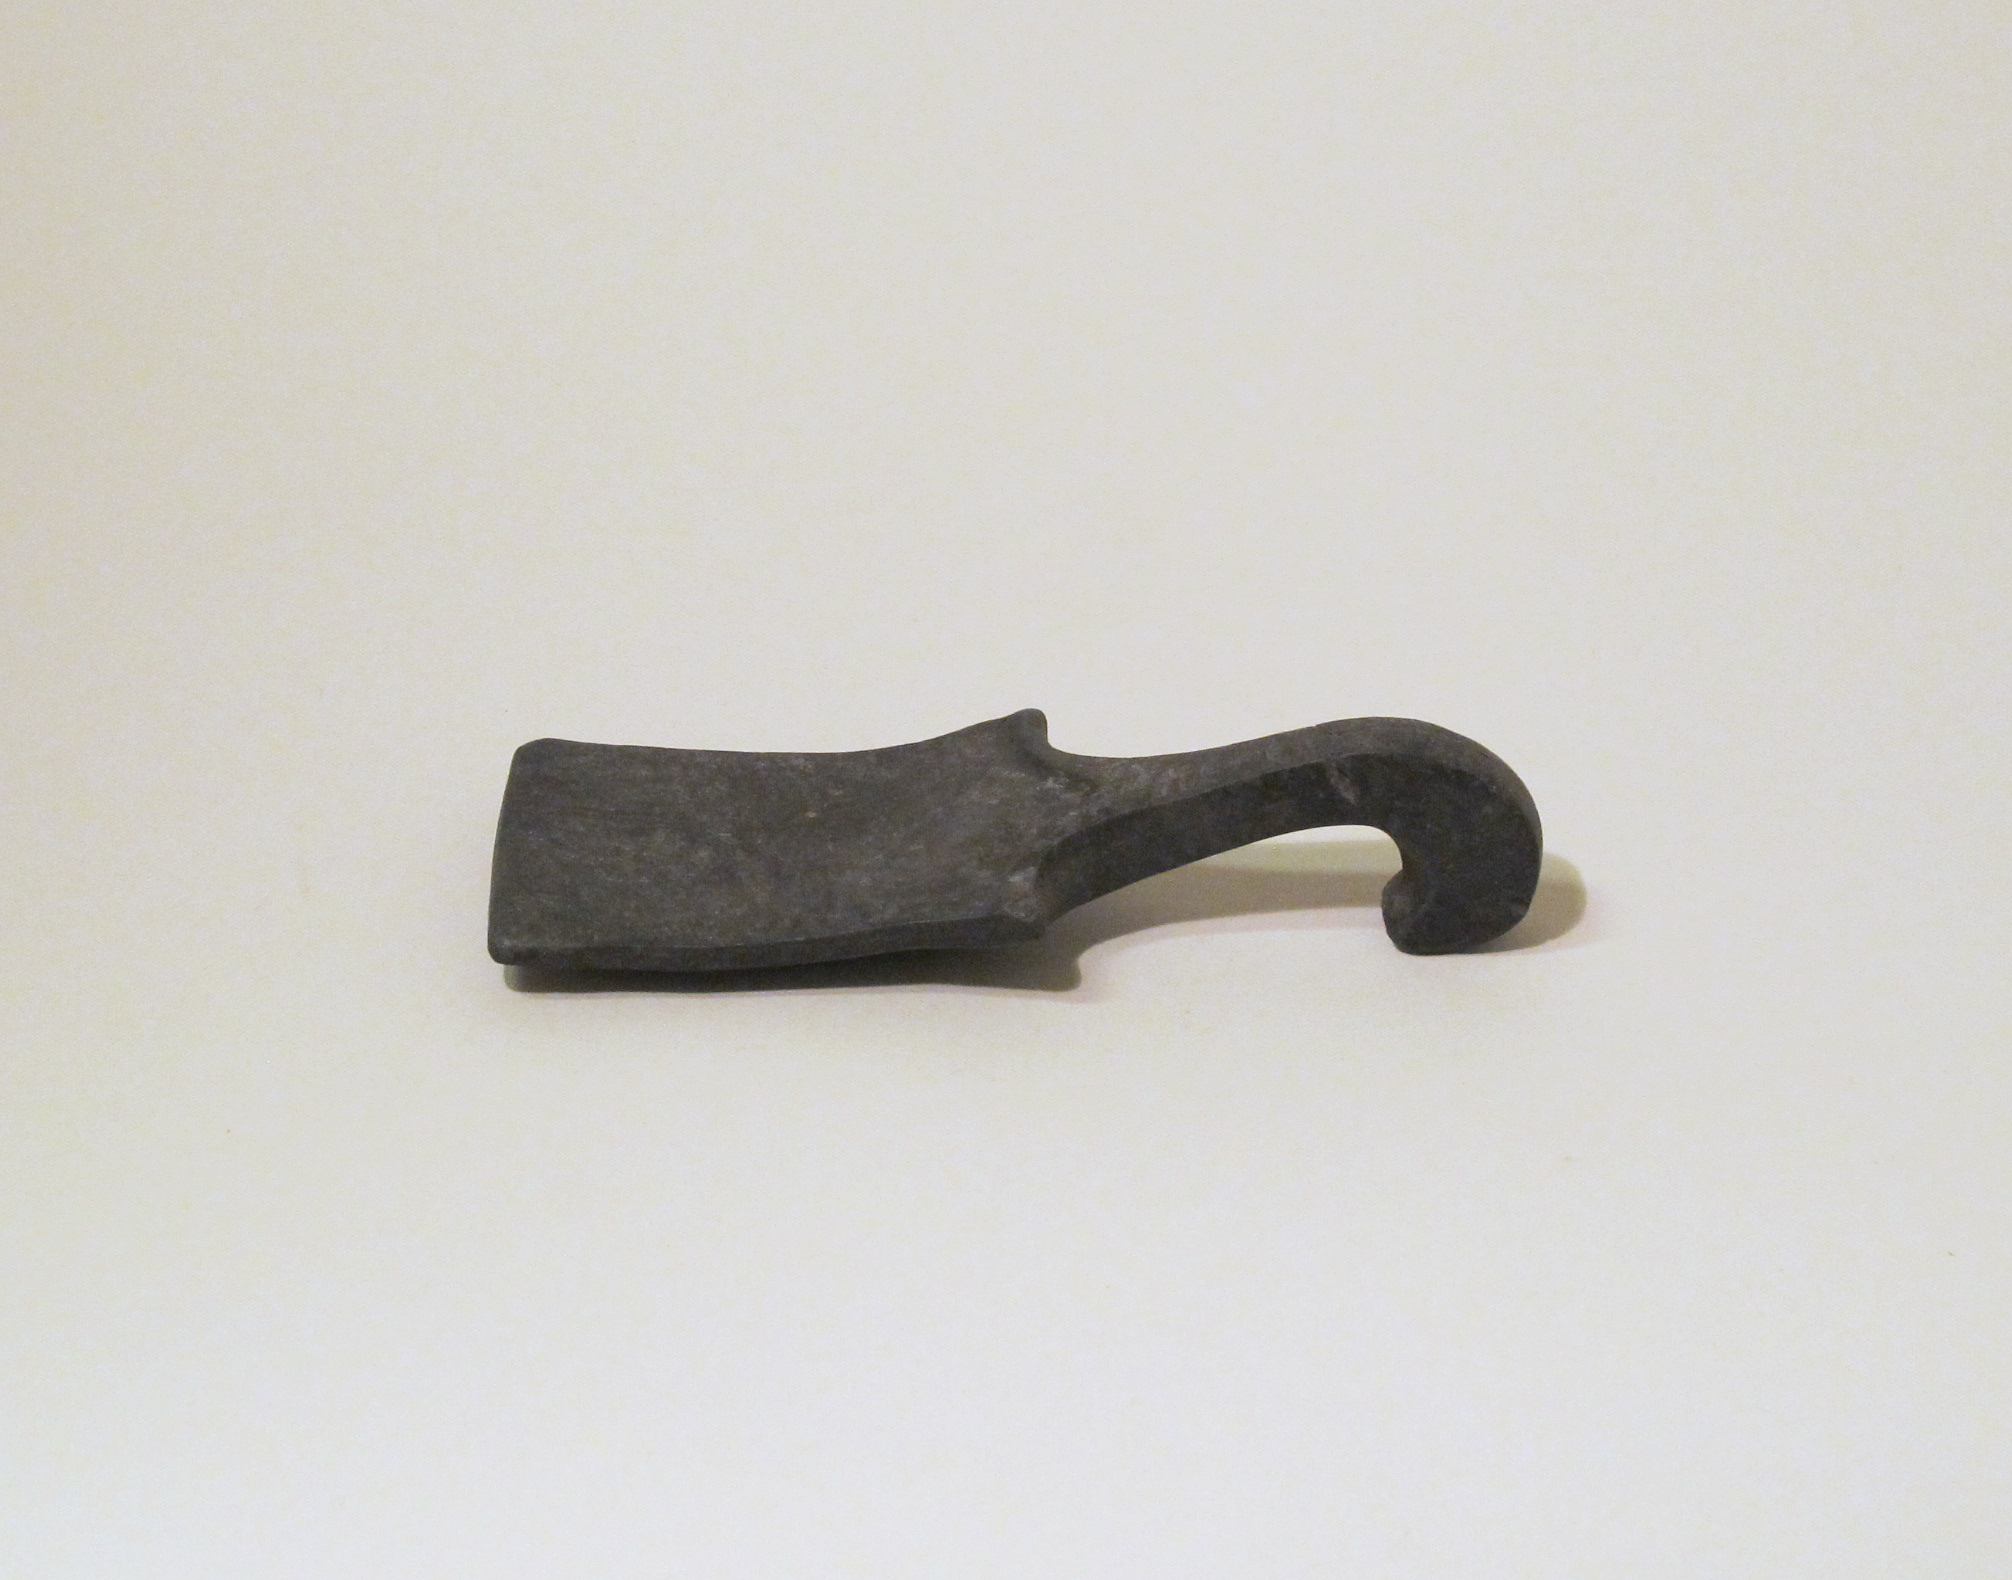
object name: focolare spoon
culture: etruscan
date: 550-501 BCE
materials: terracotta